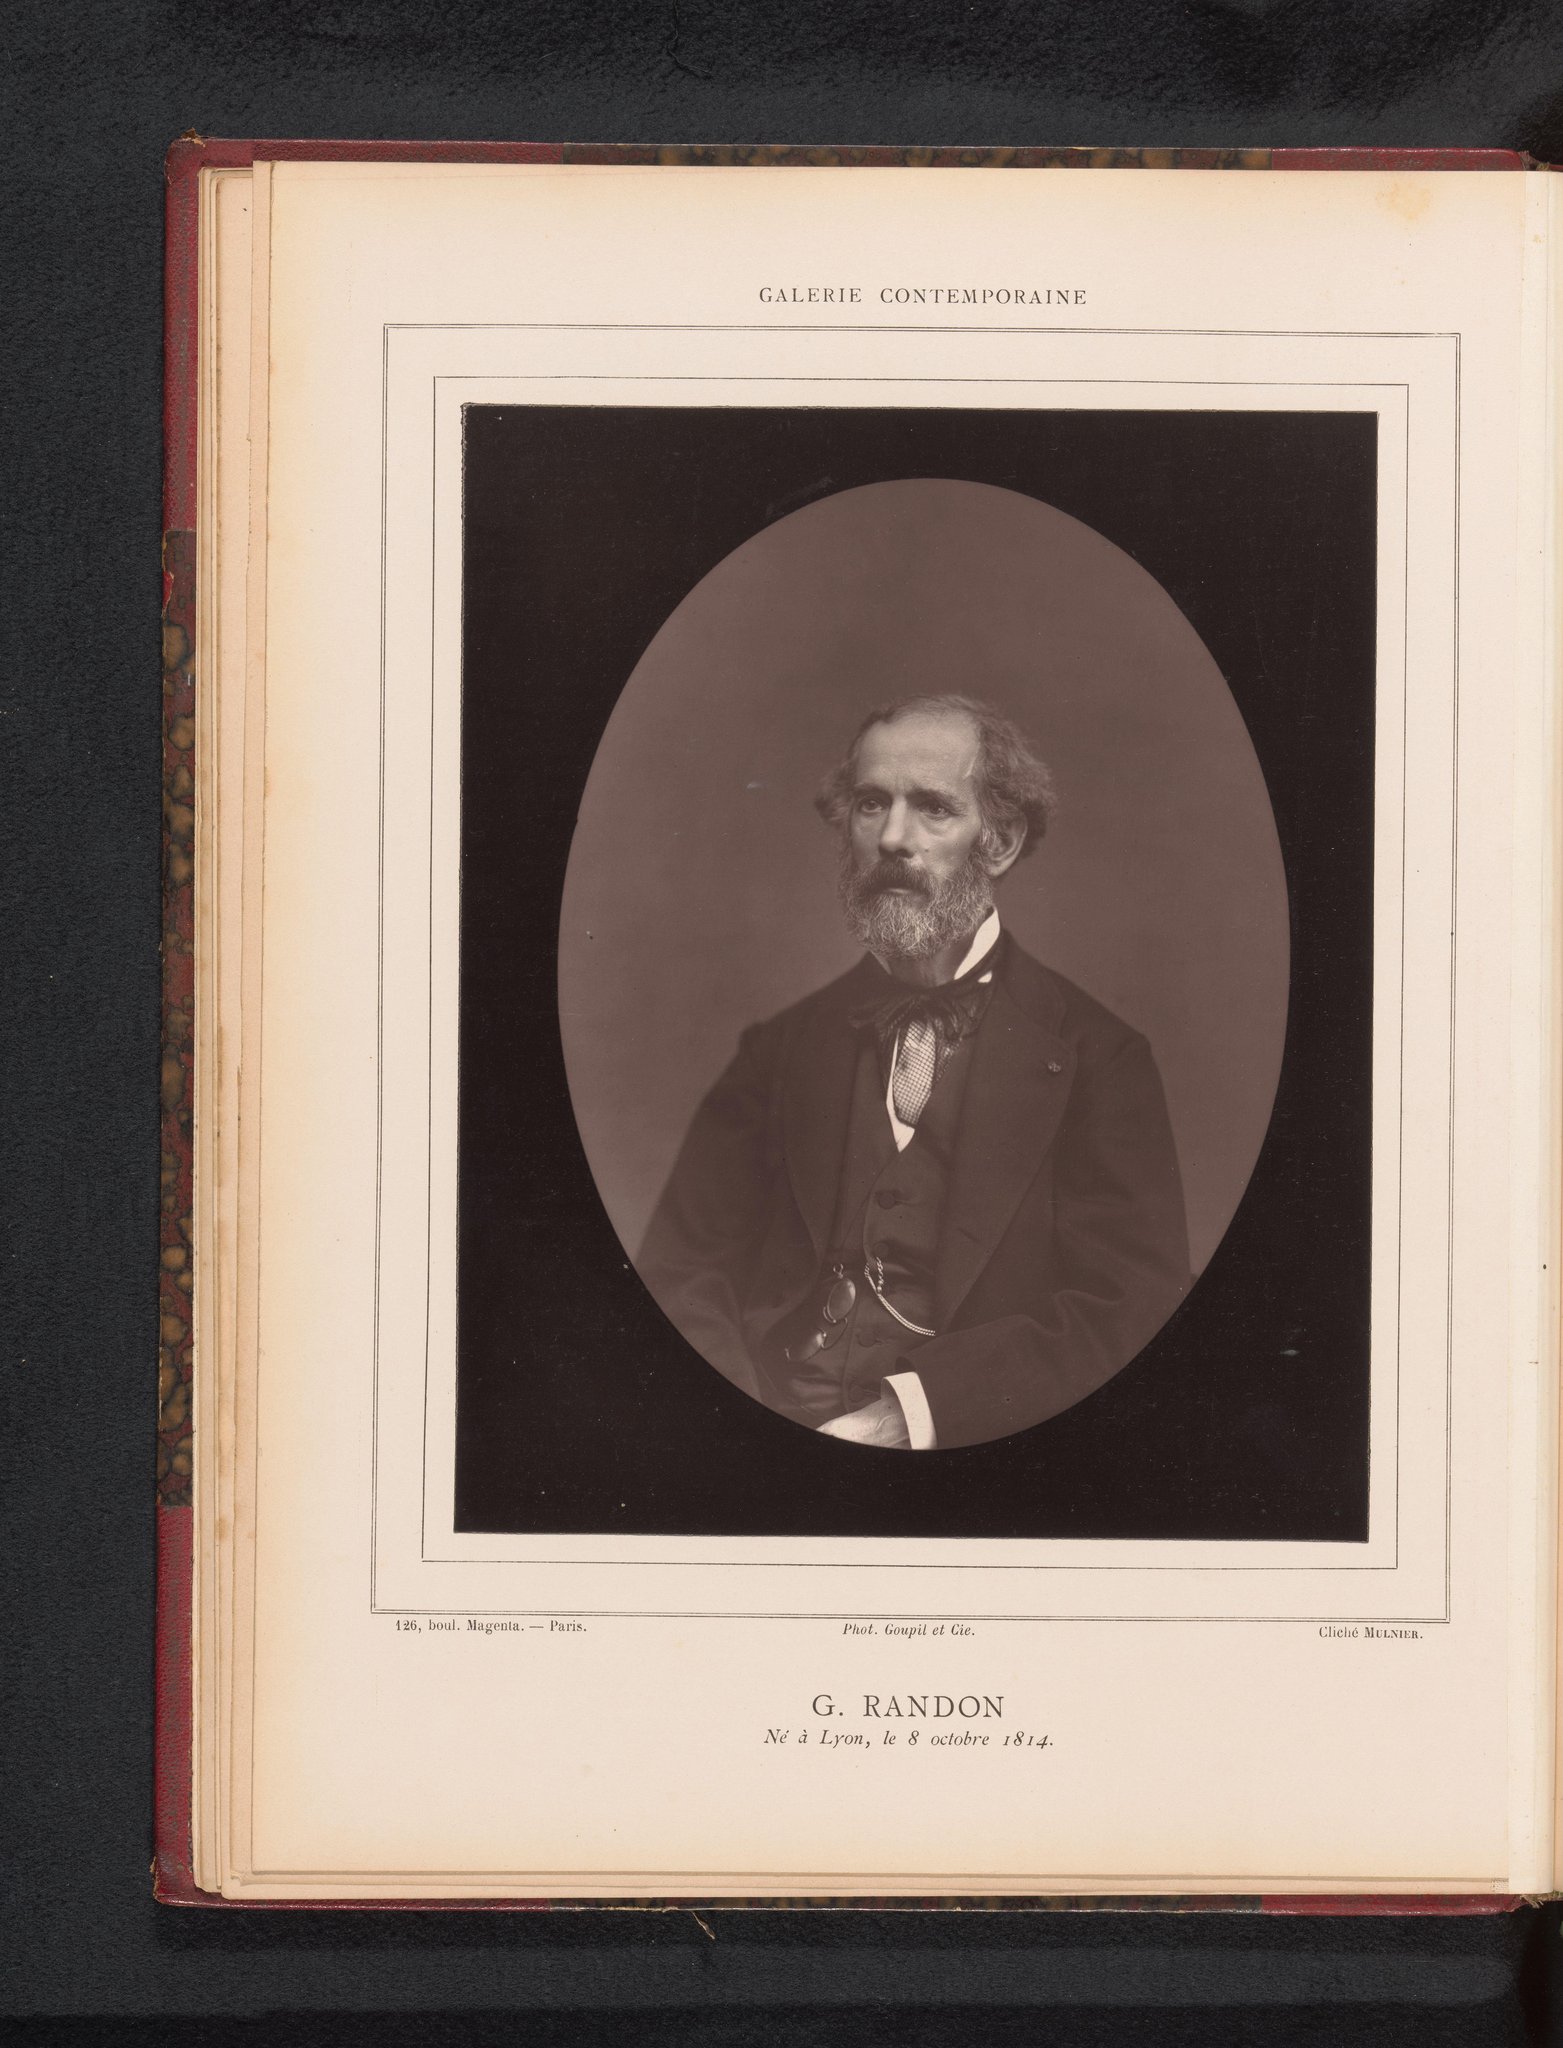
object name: page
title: Portret van Gilbert Randon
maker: ferdinand mulnier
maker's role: painter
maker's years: 1817-1891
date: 1867-1880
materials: paper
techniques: woodburytype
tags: lyon, print maker, gilbert randon, adult man, historical persons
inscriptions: inscription: ‘Galerie Contemporaine/ 126, boul. Magenta. - Paris./ Né a Lyon, le 8 octobre 1814’